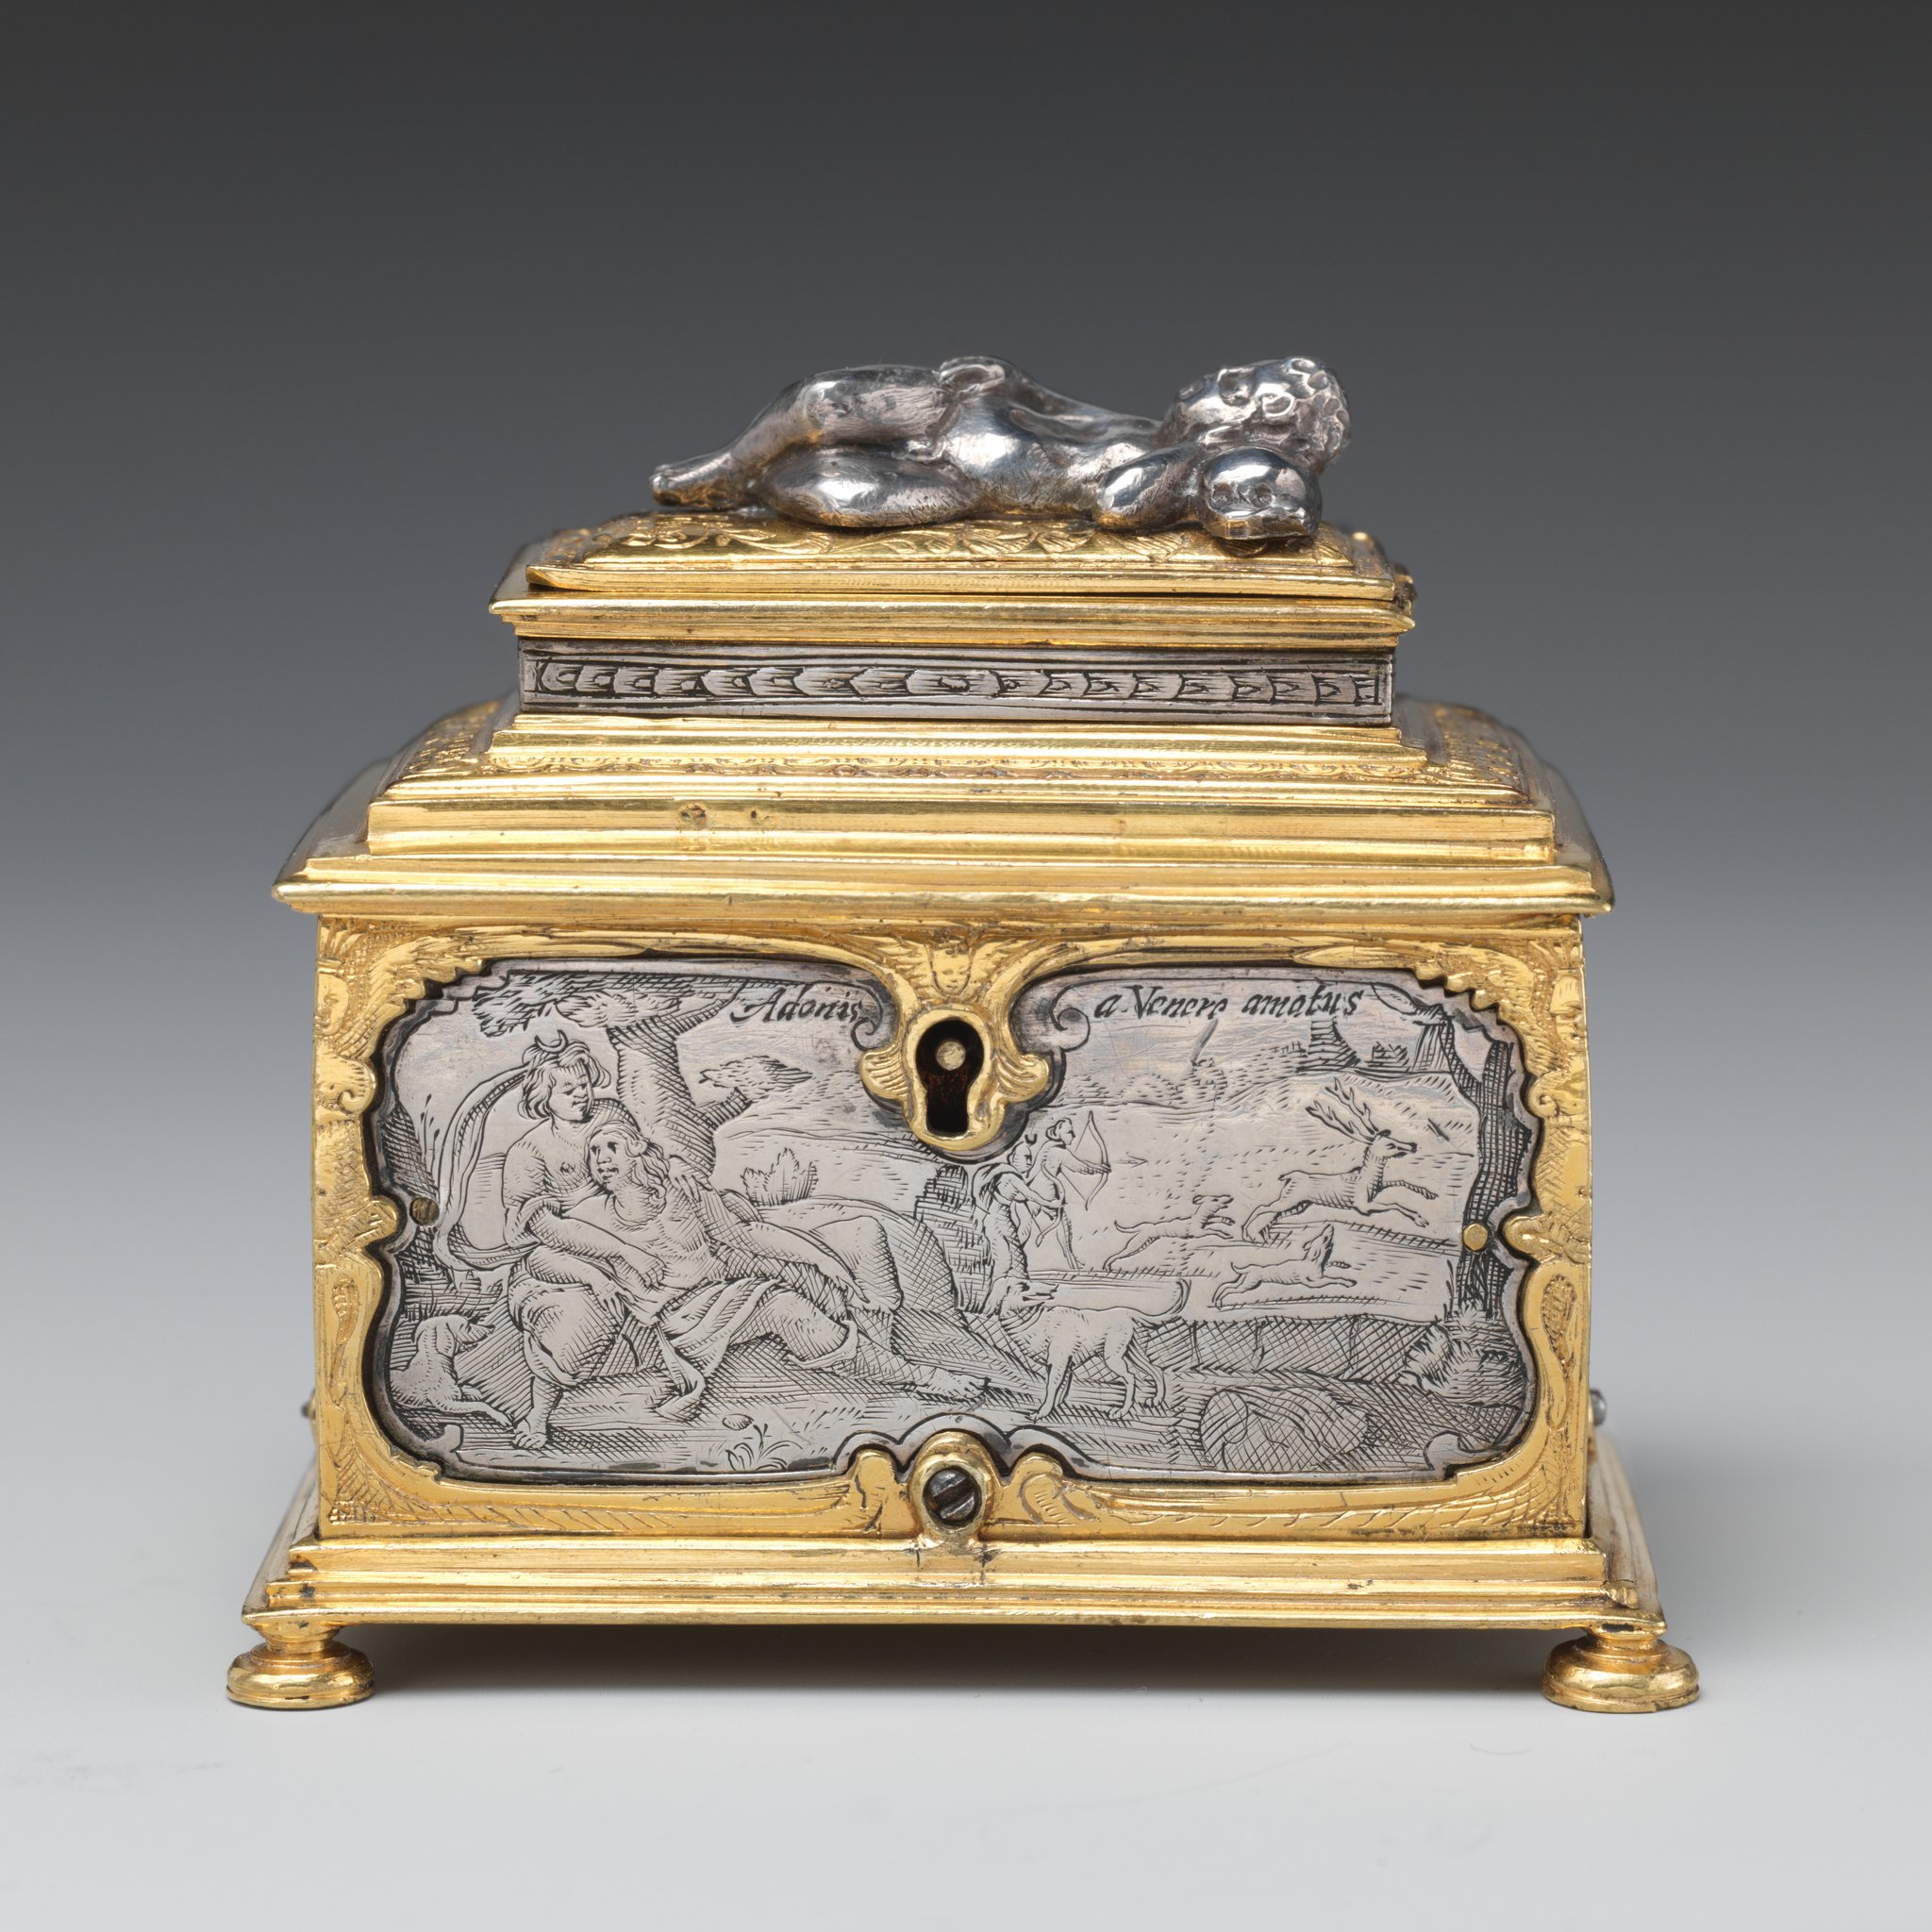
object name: jewelry box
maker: p. ben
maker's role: maker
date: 1627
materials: brass, gilt, silver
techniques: engraving